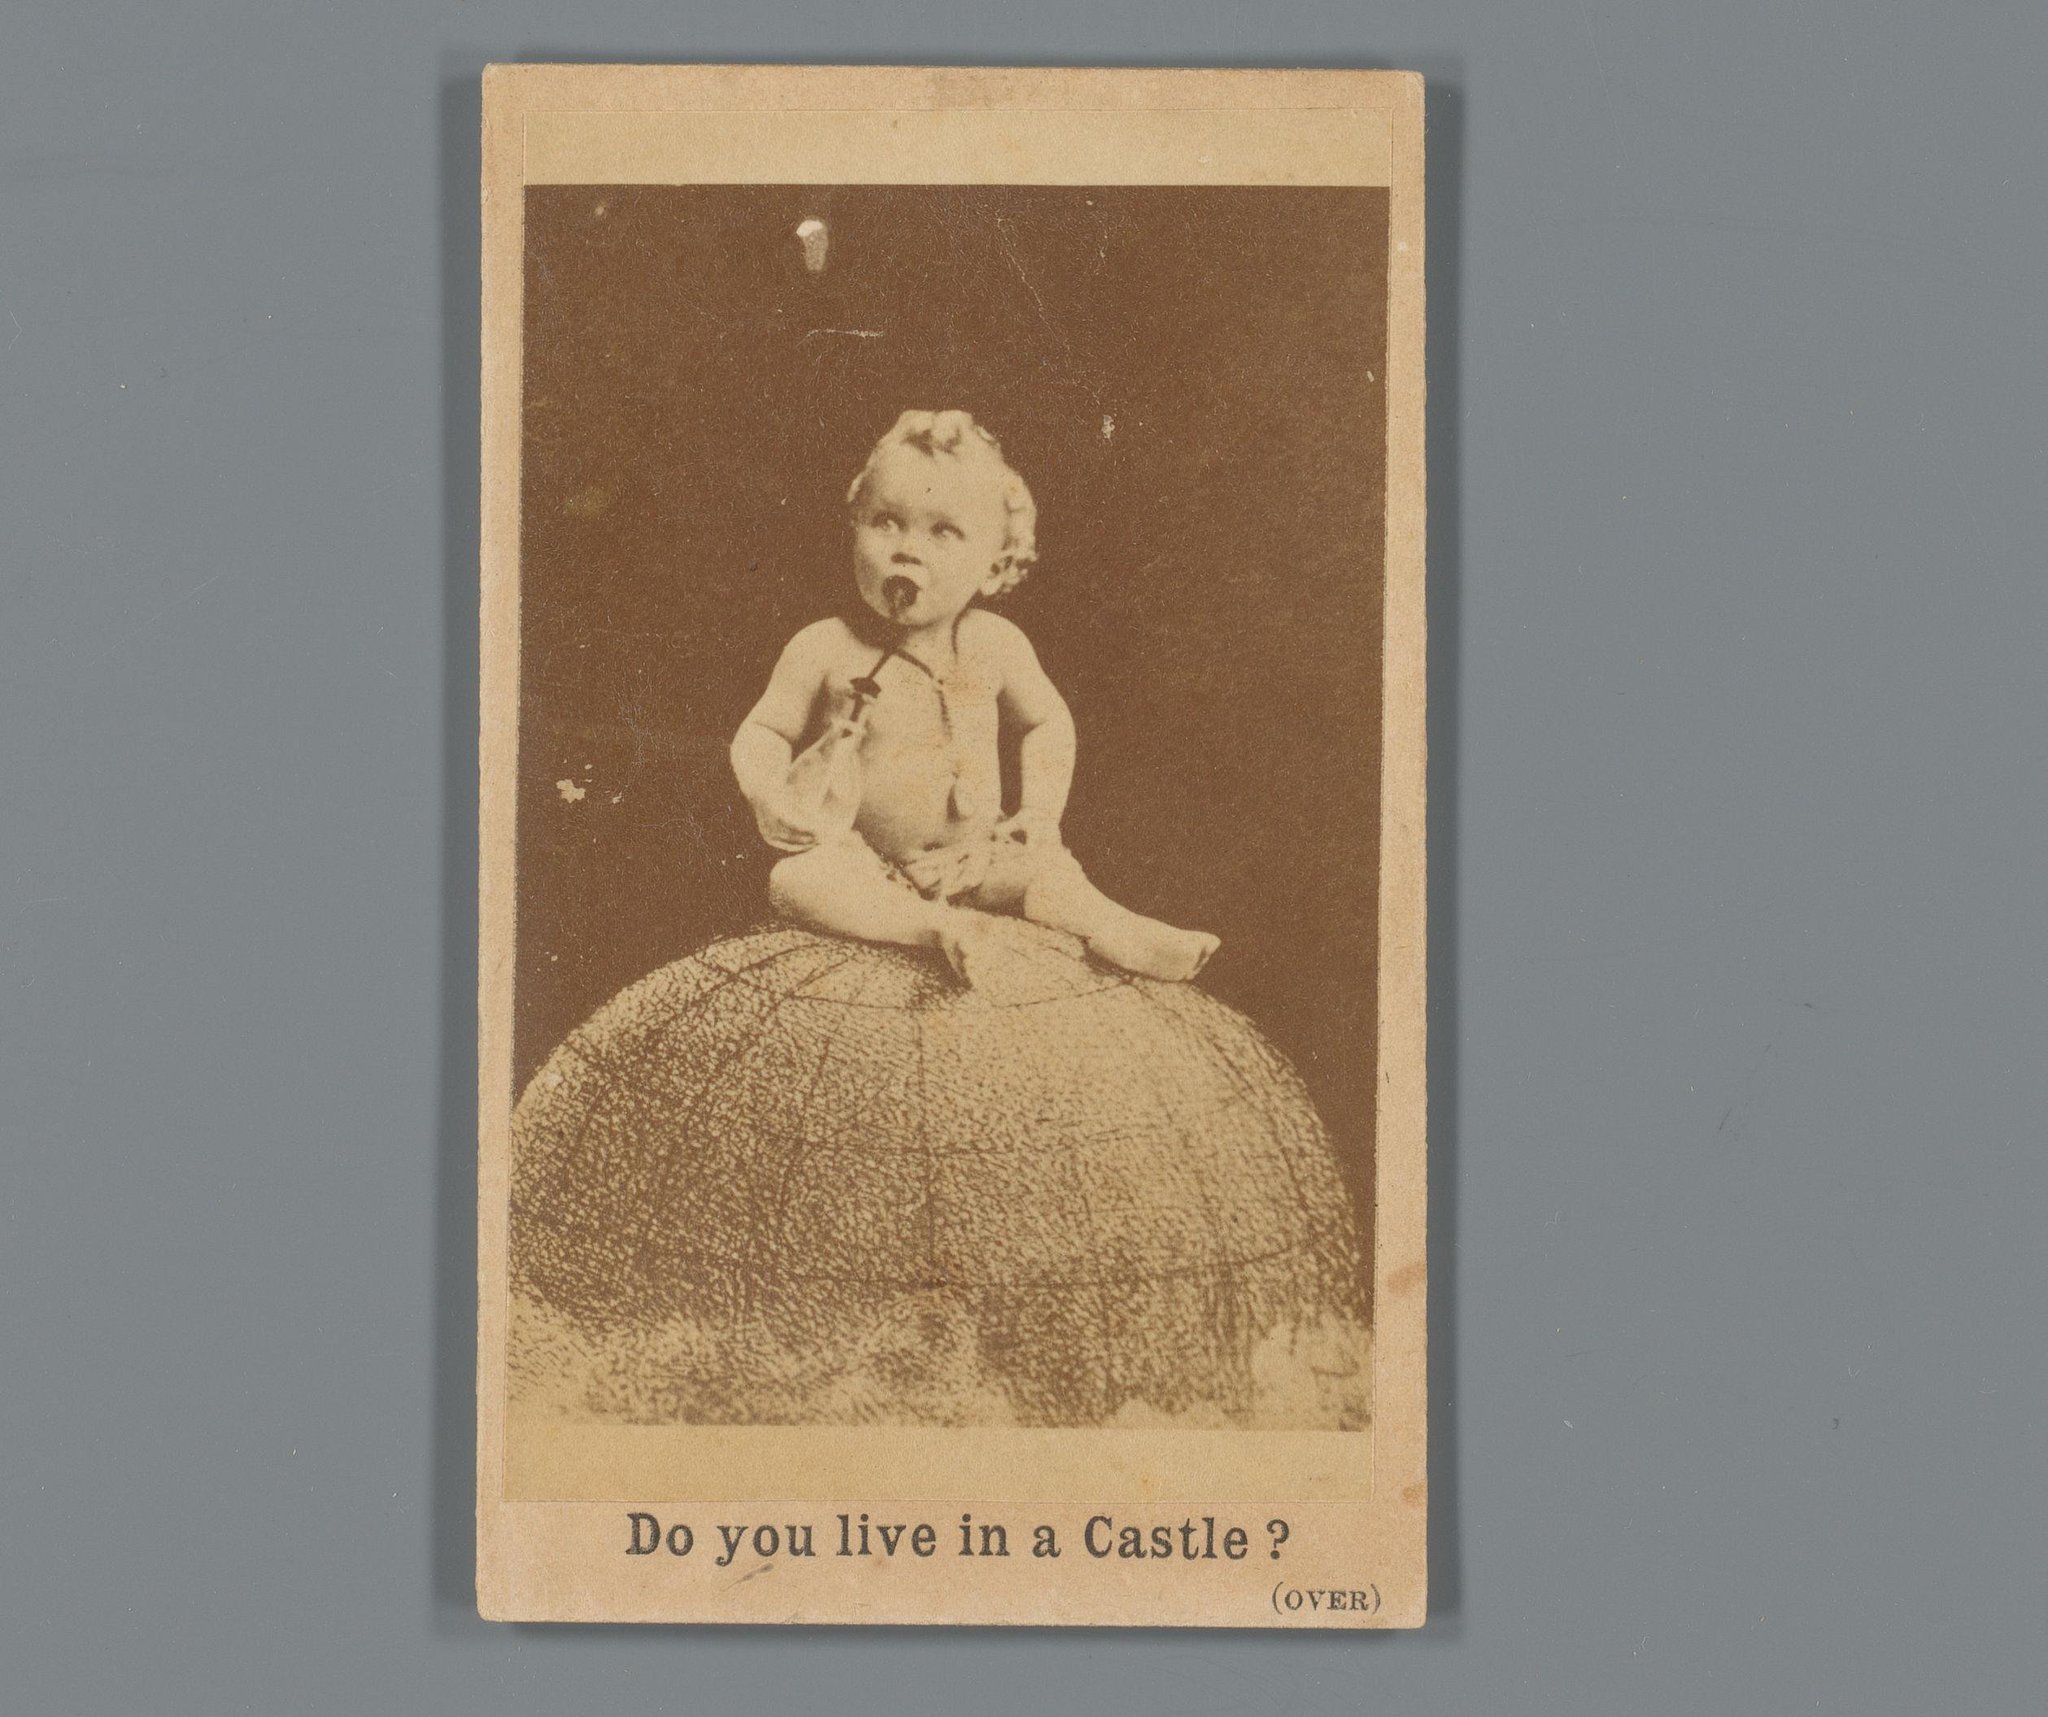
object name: photograph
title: Will you live in a castle?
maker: Anonymous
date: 1850-1915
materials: cardboard, photographic support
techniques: albumen print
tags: advertising, infant, baby ~ the ages of man, textile industry and clothing industry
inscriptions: inscription: ‘(...)’